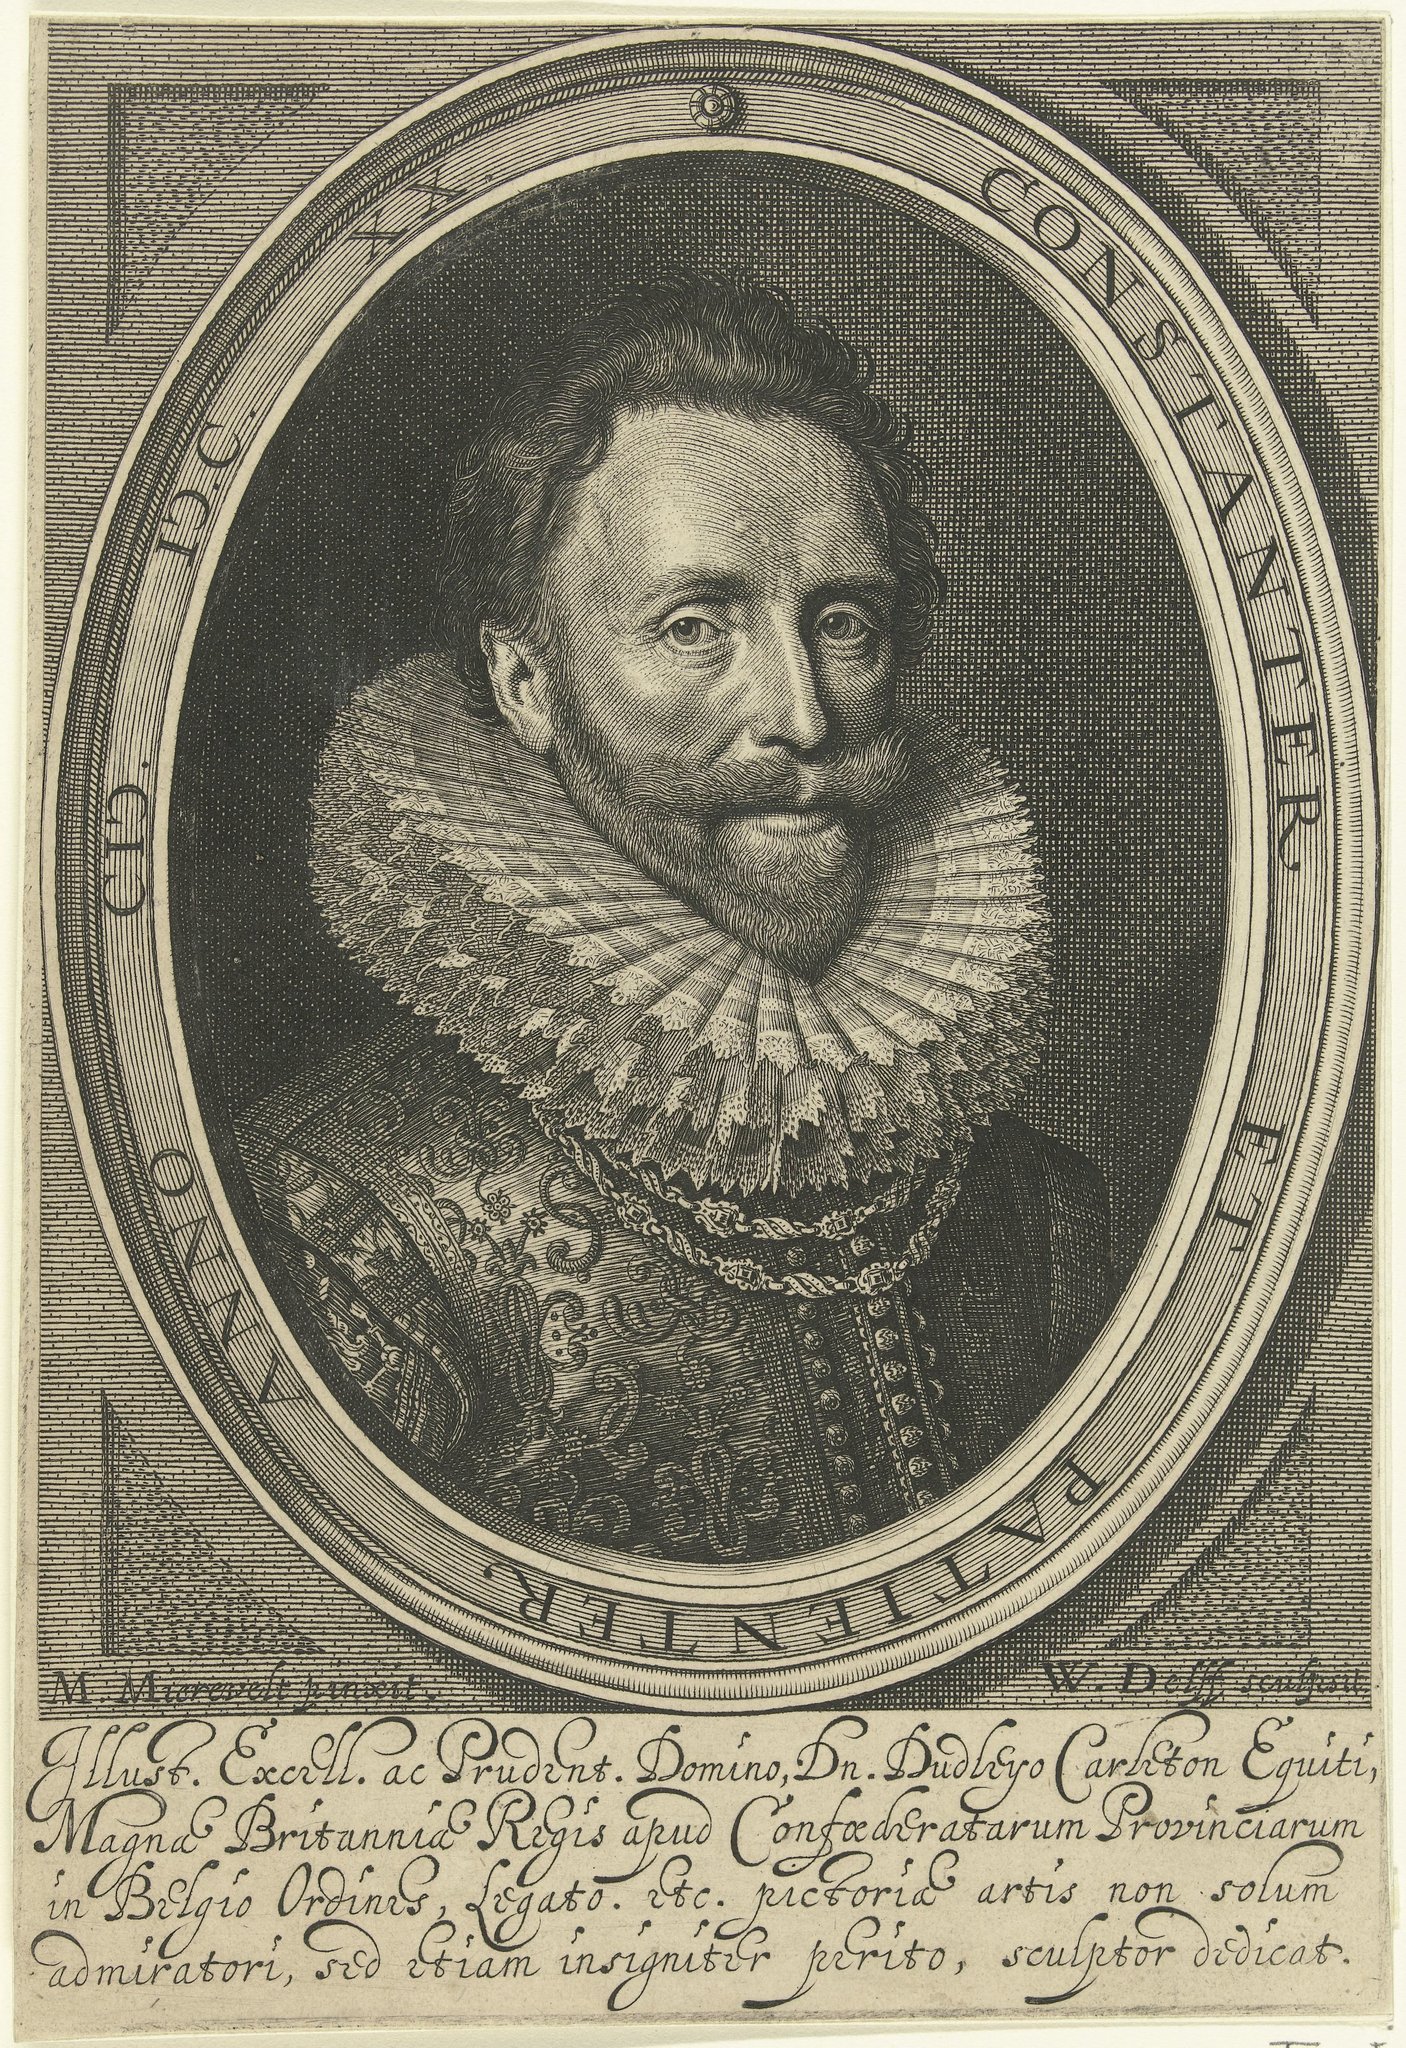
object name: print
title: Portret van Dudley Carlton, graaf van Dorchester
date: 1620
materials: paper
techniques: engraving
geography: delft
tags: dudley carlton (graaf van dorchester)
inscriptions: collector's mark: Lugt 2228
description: Portret van Dudley Carlton, graaf van Dorchester, borststuk met molenkraag in ovale omlijsting met motto, in ondermarge Latijns opschrift.